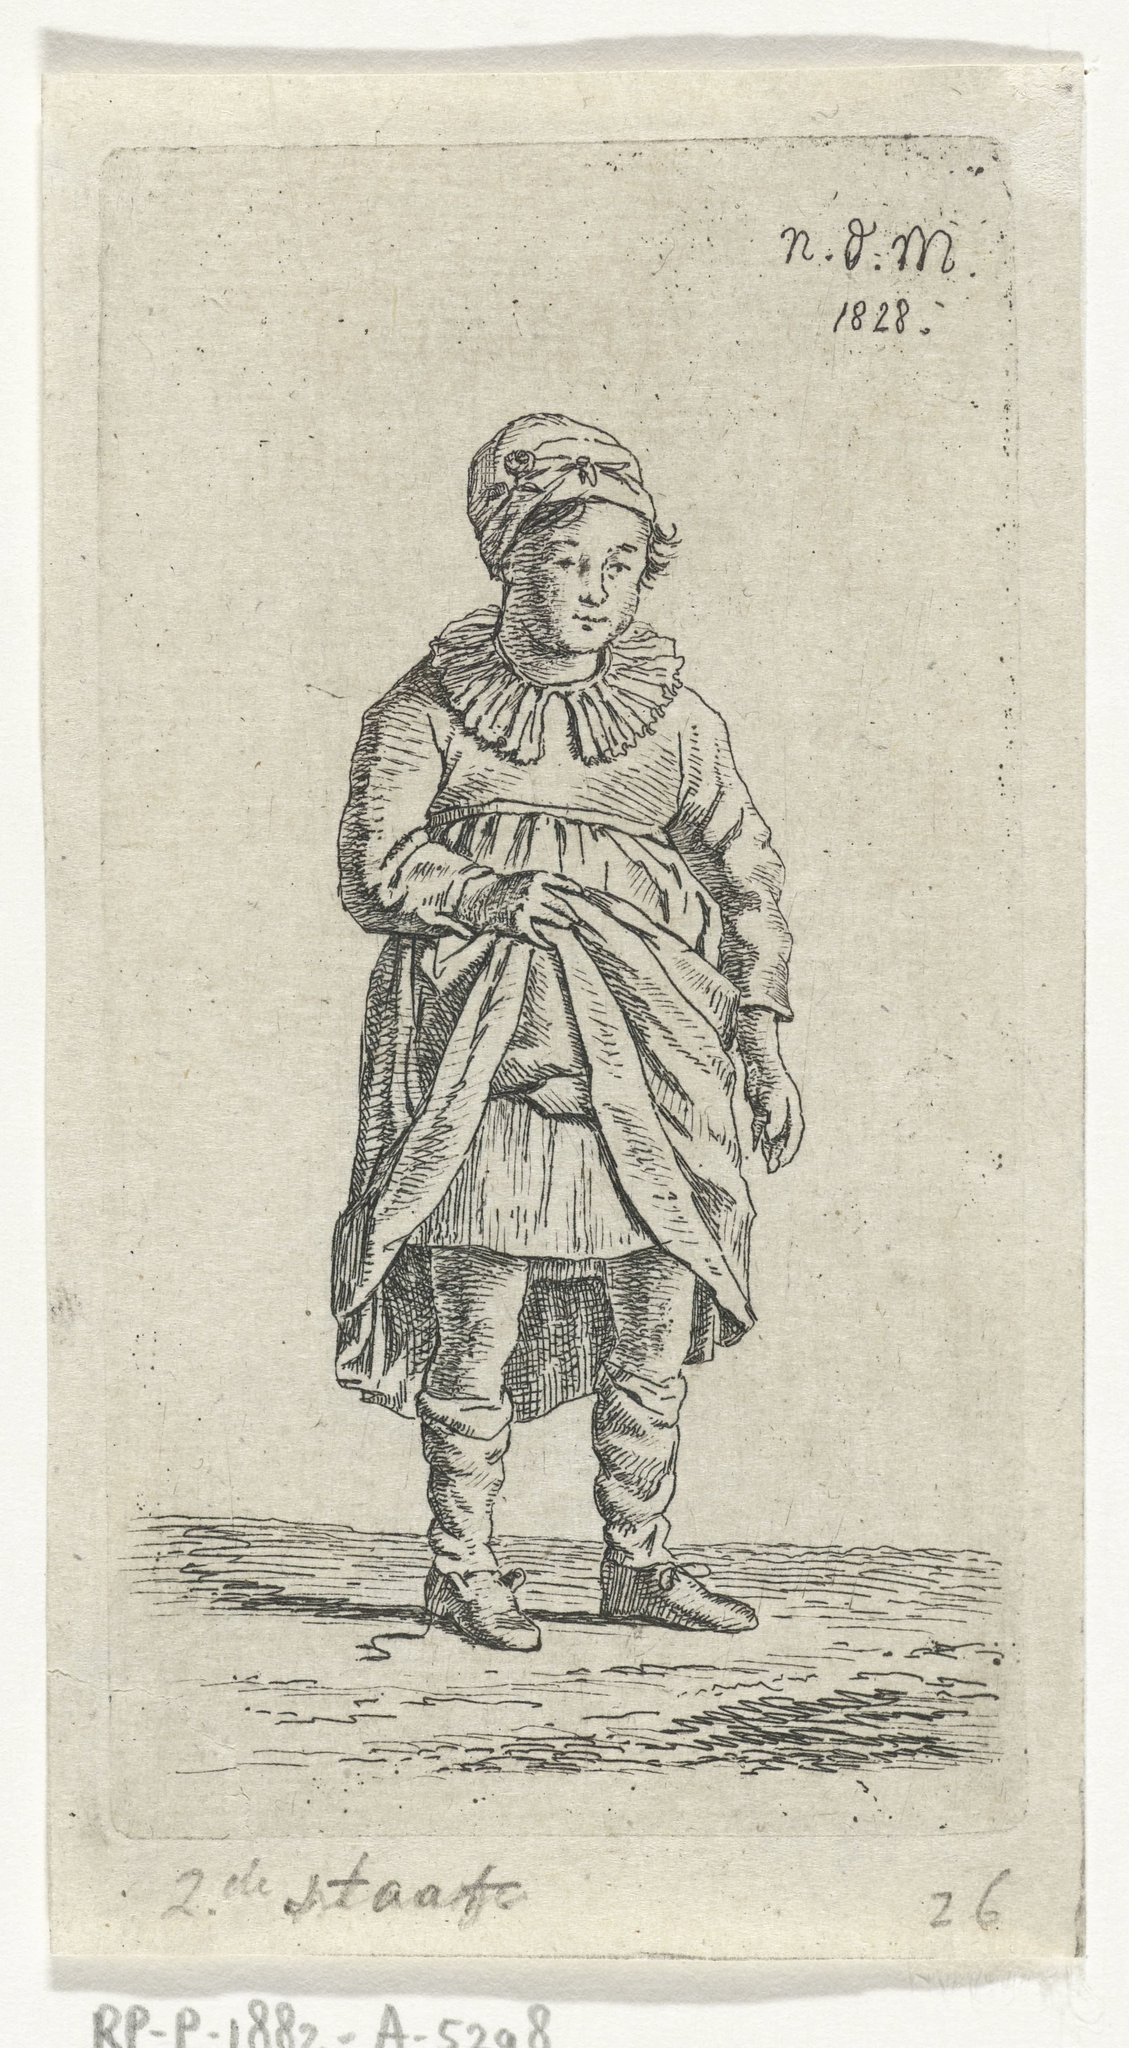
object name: print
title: Meisje dat haar rok optilt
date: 1828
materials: paper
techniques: etching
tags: skirt (+ girls' clothes), head-gear: cap (+ girls' clothes), girl (child between toddler and youth)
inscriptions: collector's mark: Lugt 2228